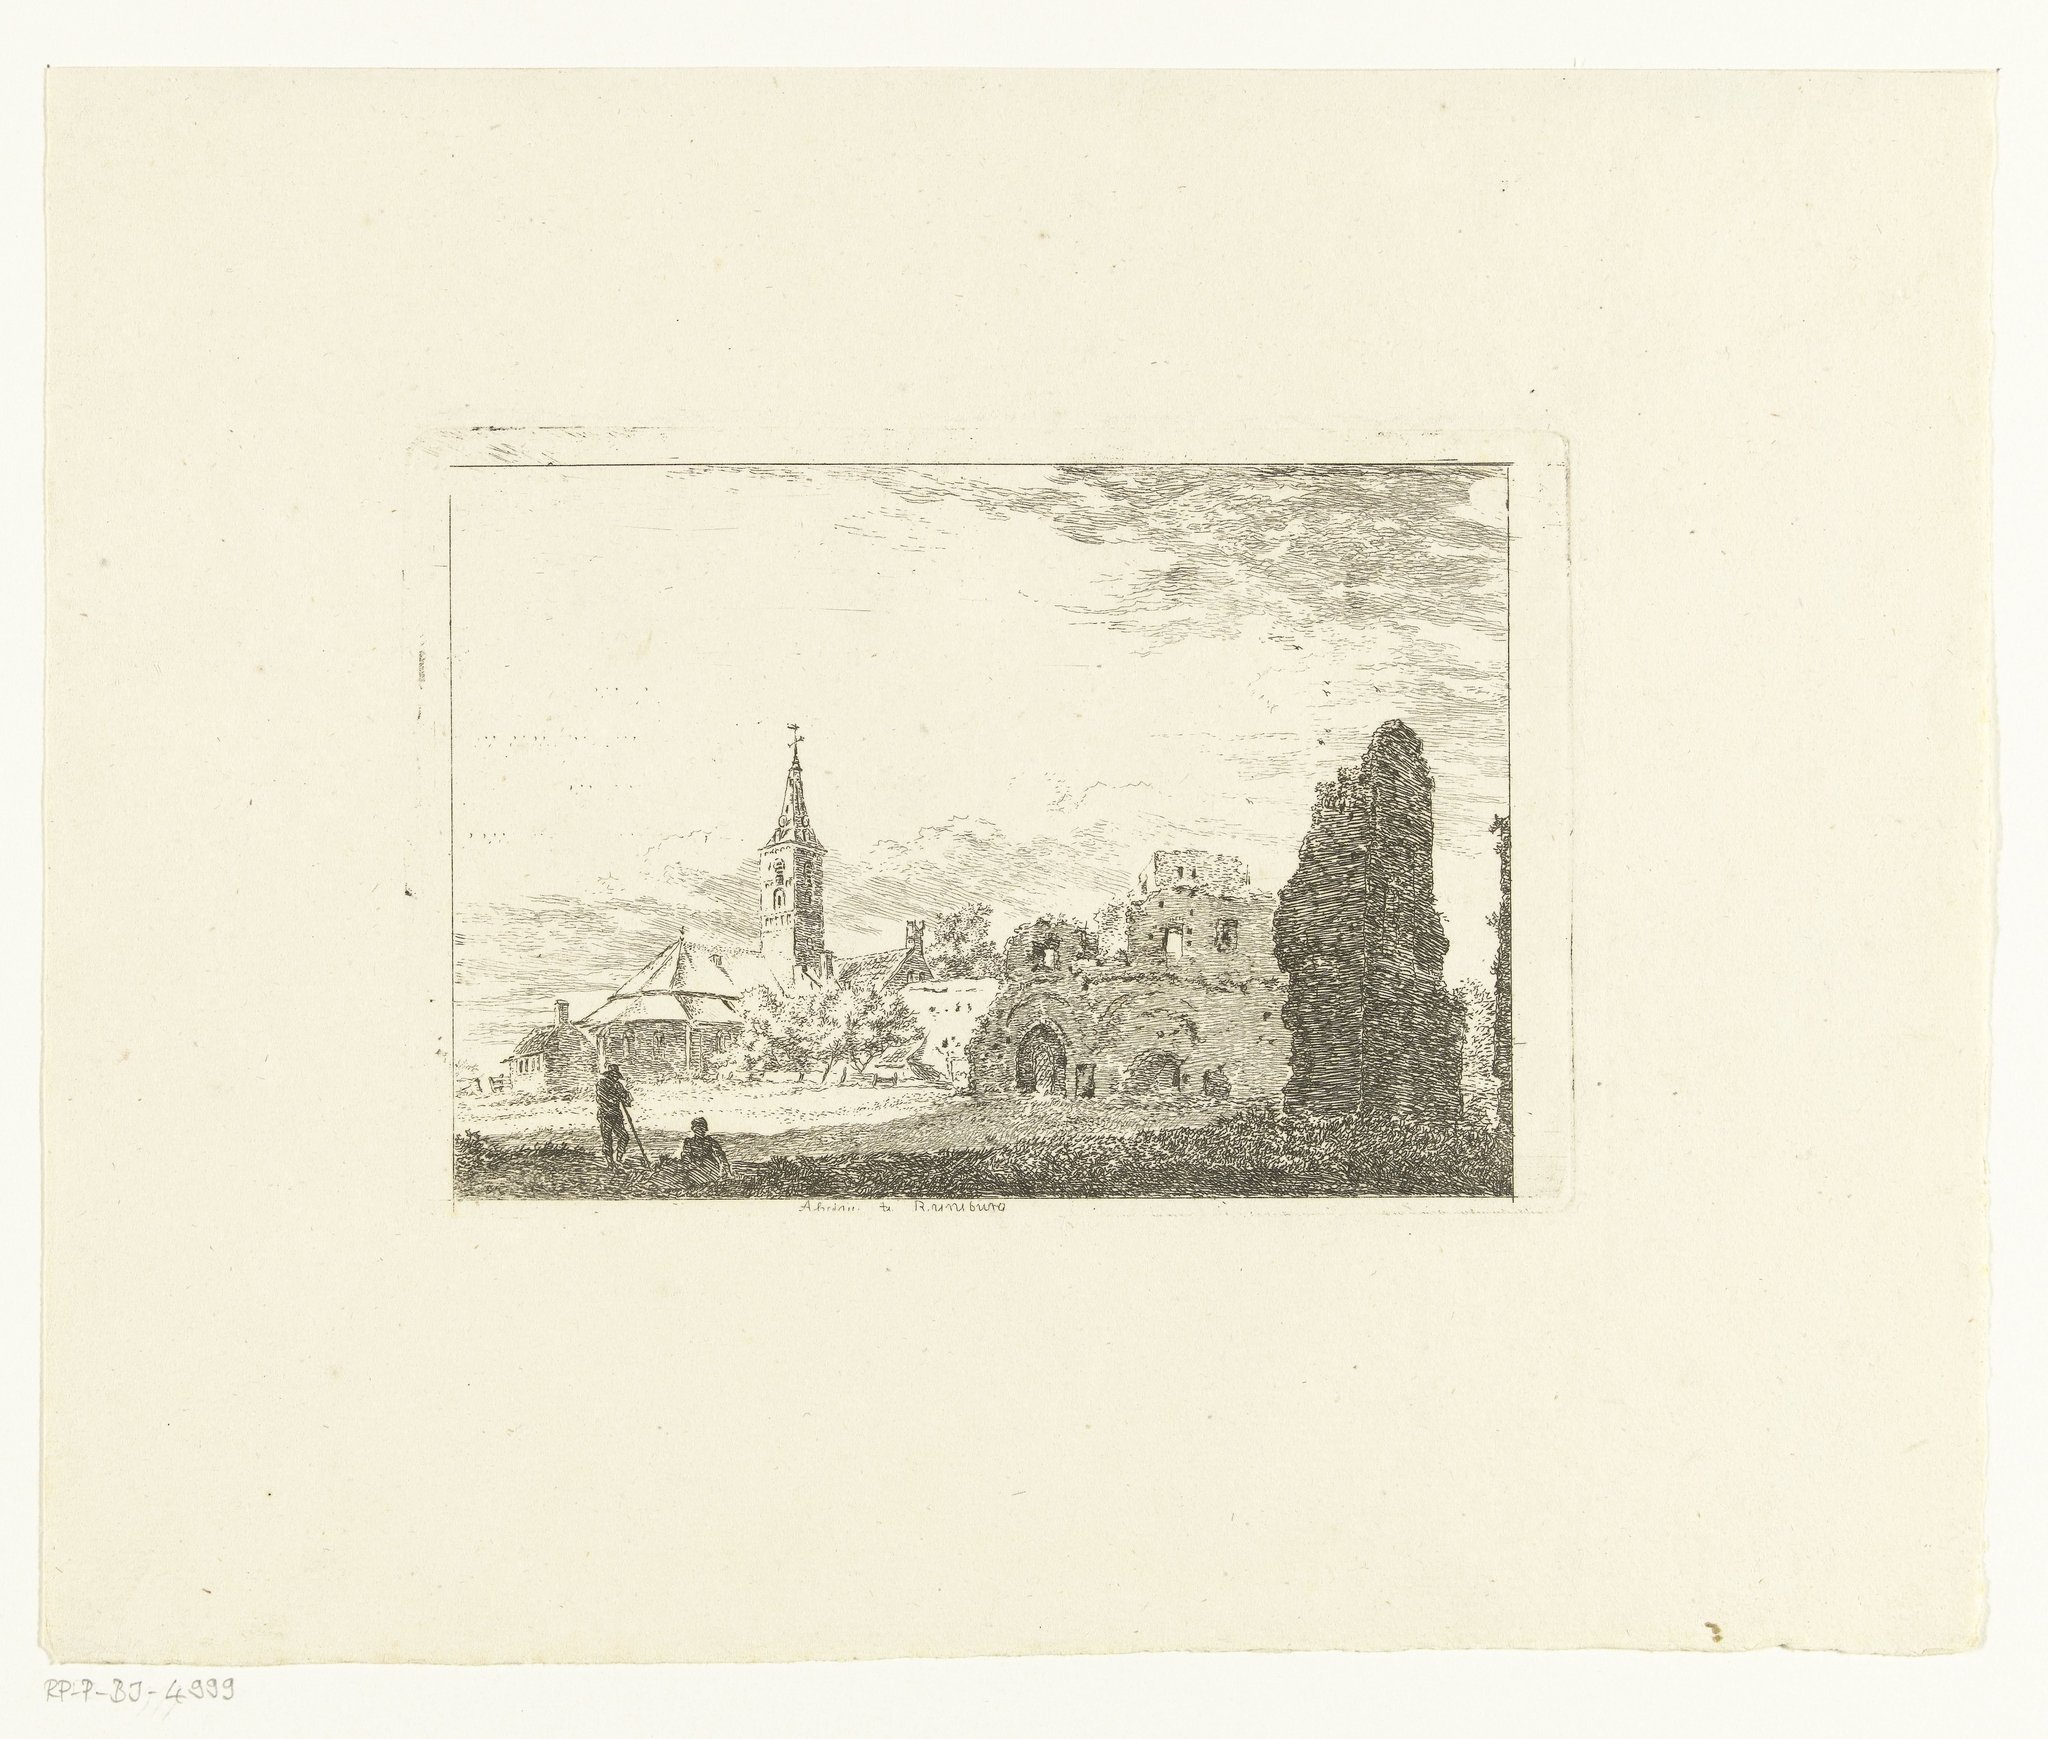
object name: print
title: Abdije te Rynsburg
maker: hermanus van brussel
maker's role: draughtsman, print maker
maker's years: 1763-1815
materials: paper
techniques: etching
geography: netherlands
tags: landscapes in the temperate zone, ruin of church, monastery, etc.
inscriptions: collector's mark: Lugt 2228